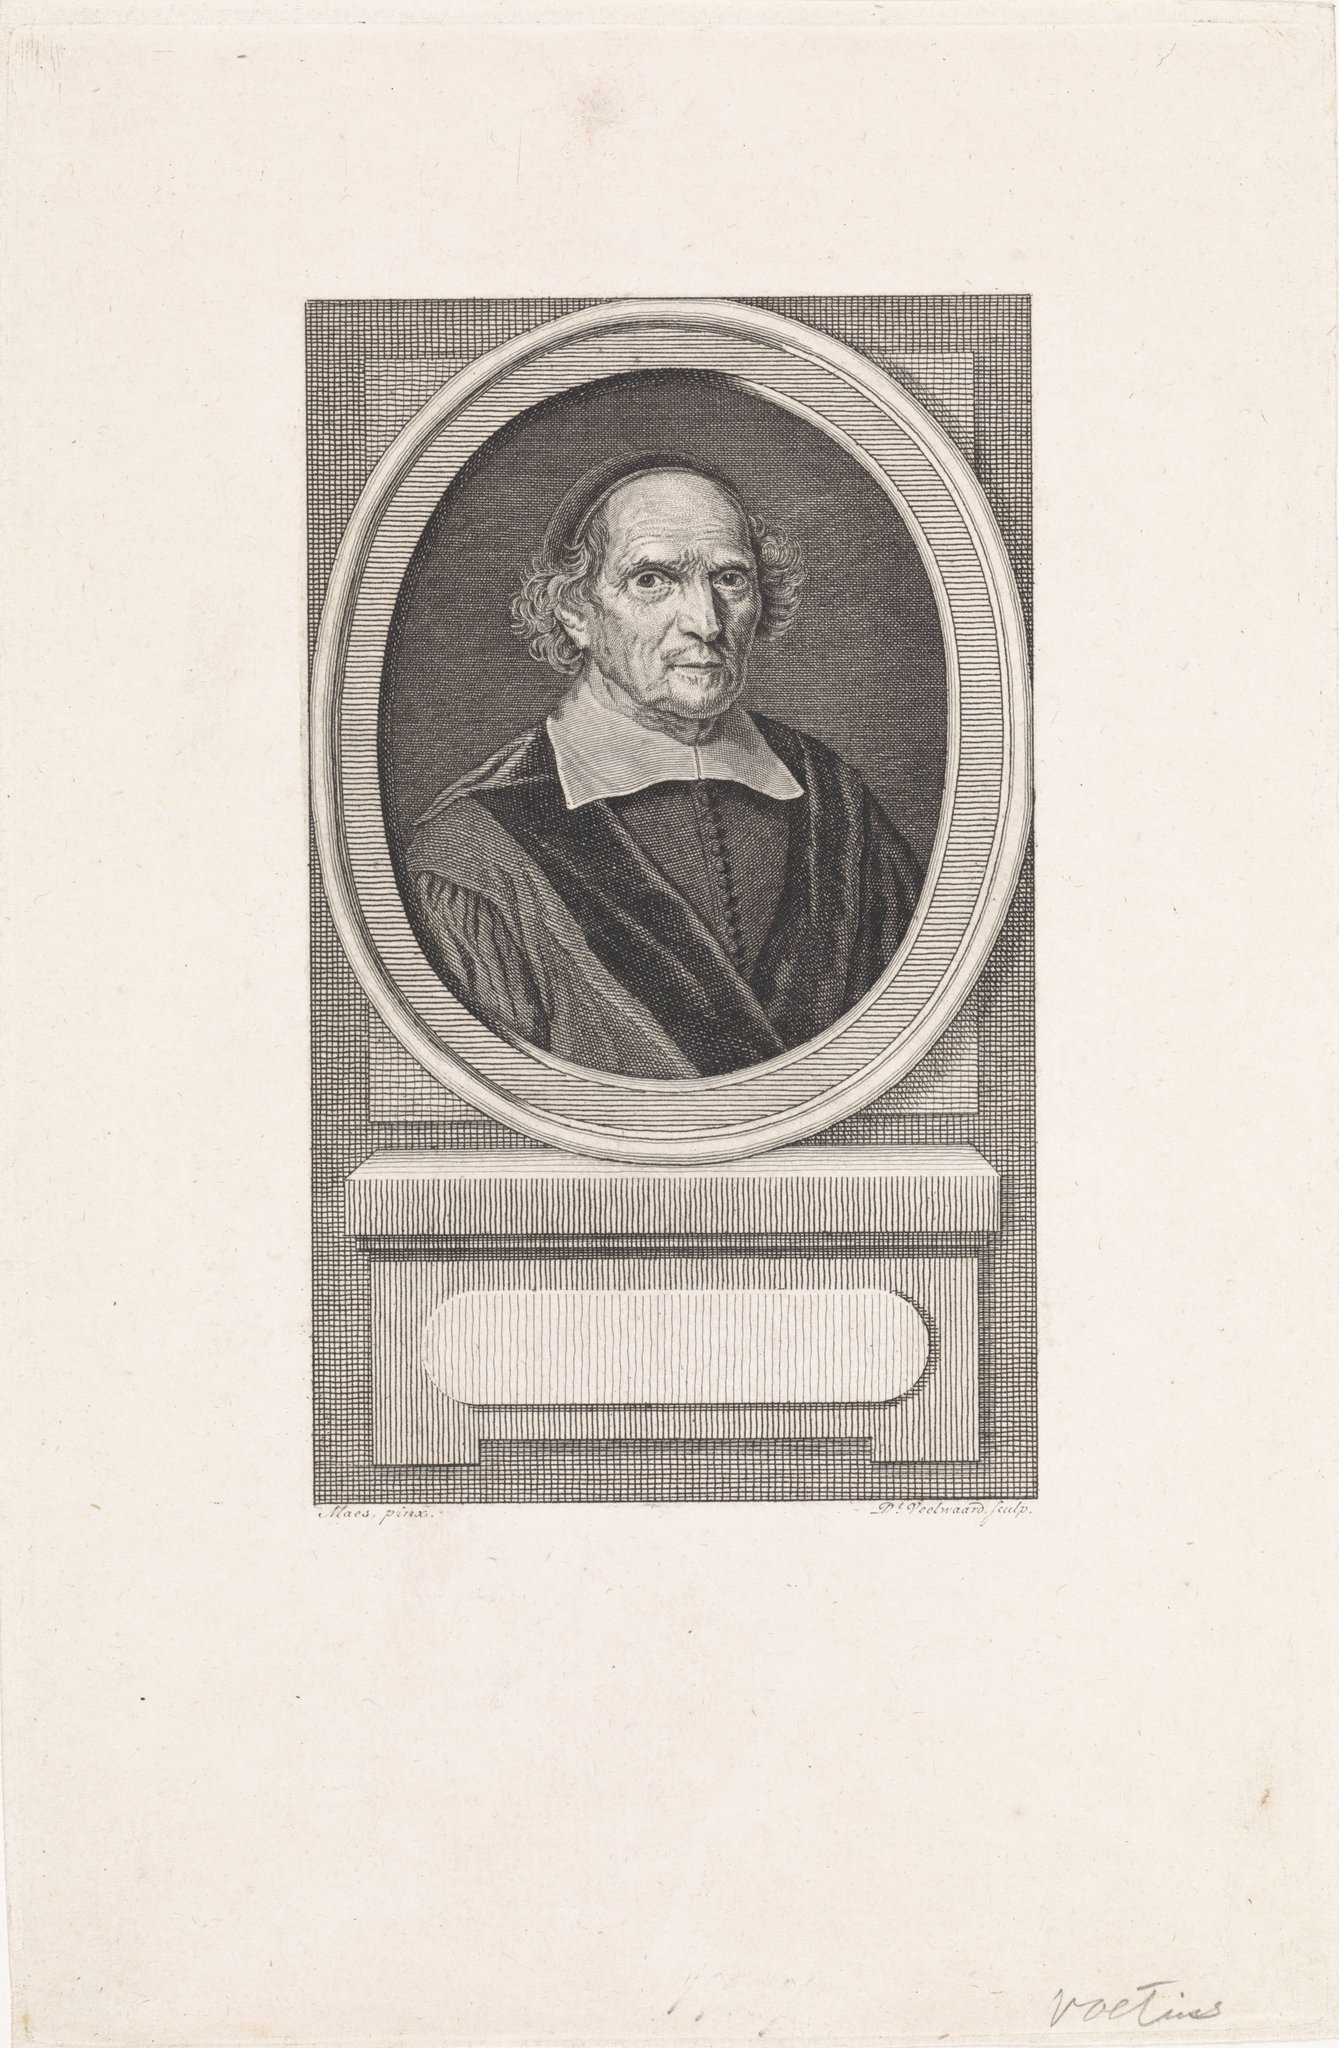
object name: print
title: Portret van de theoloog Gisbertus Voetius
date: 1776-1851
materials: paper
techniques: engraving, etching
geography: amsterdam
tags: predikant, theoloog, hoogleraar, gijsbert voet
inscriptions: number: ‘-40’, collector's mark: Lugt 2228